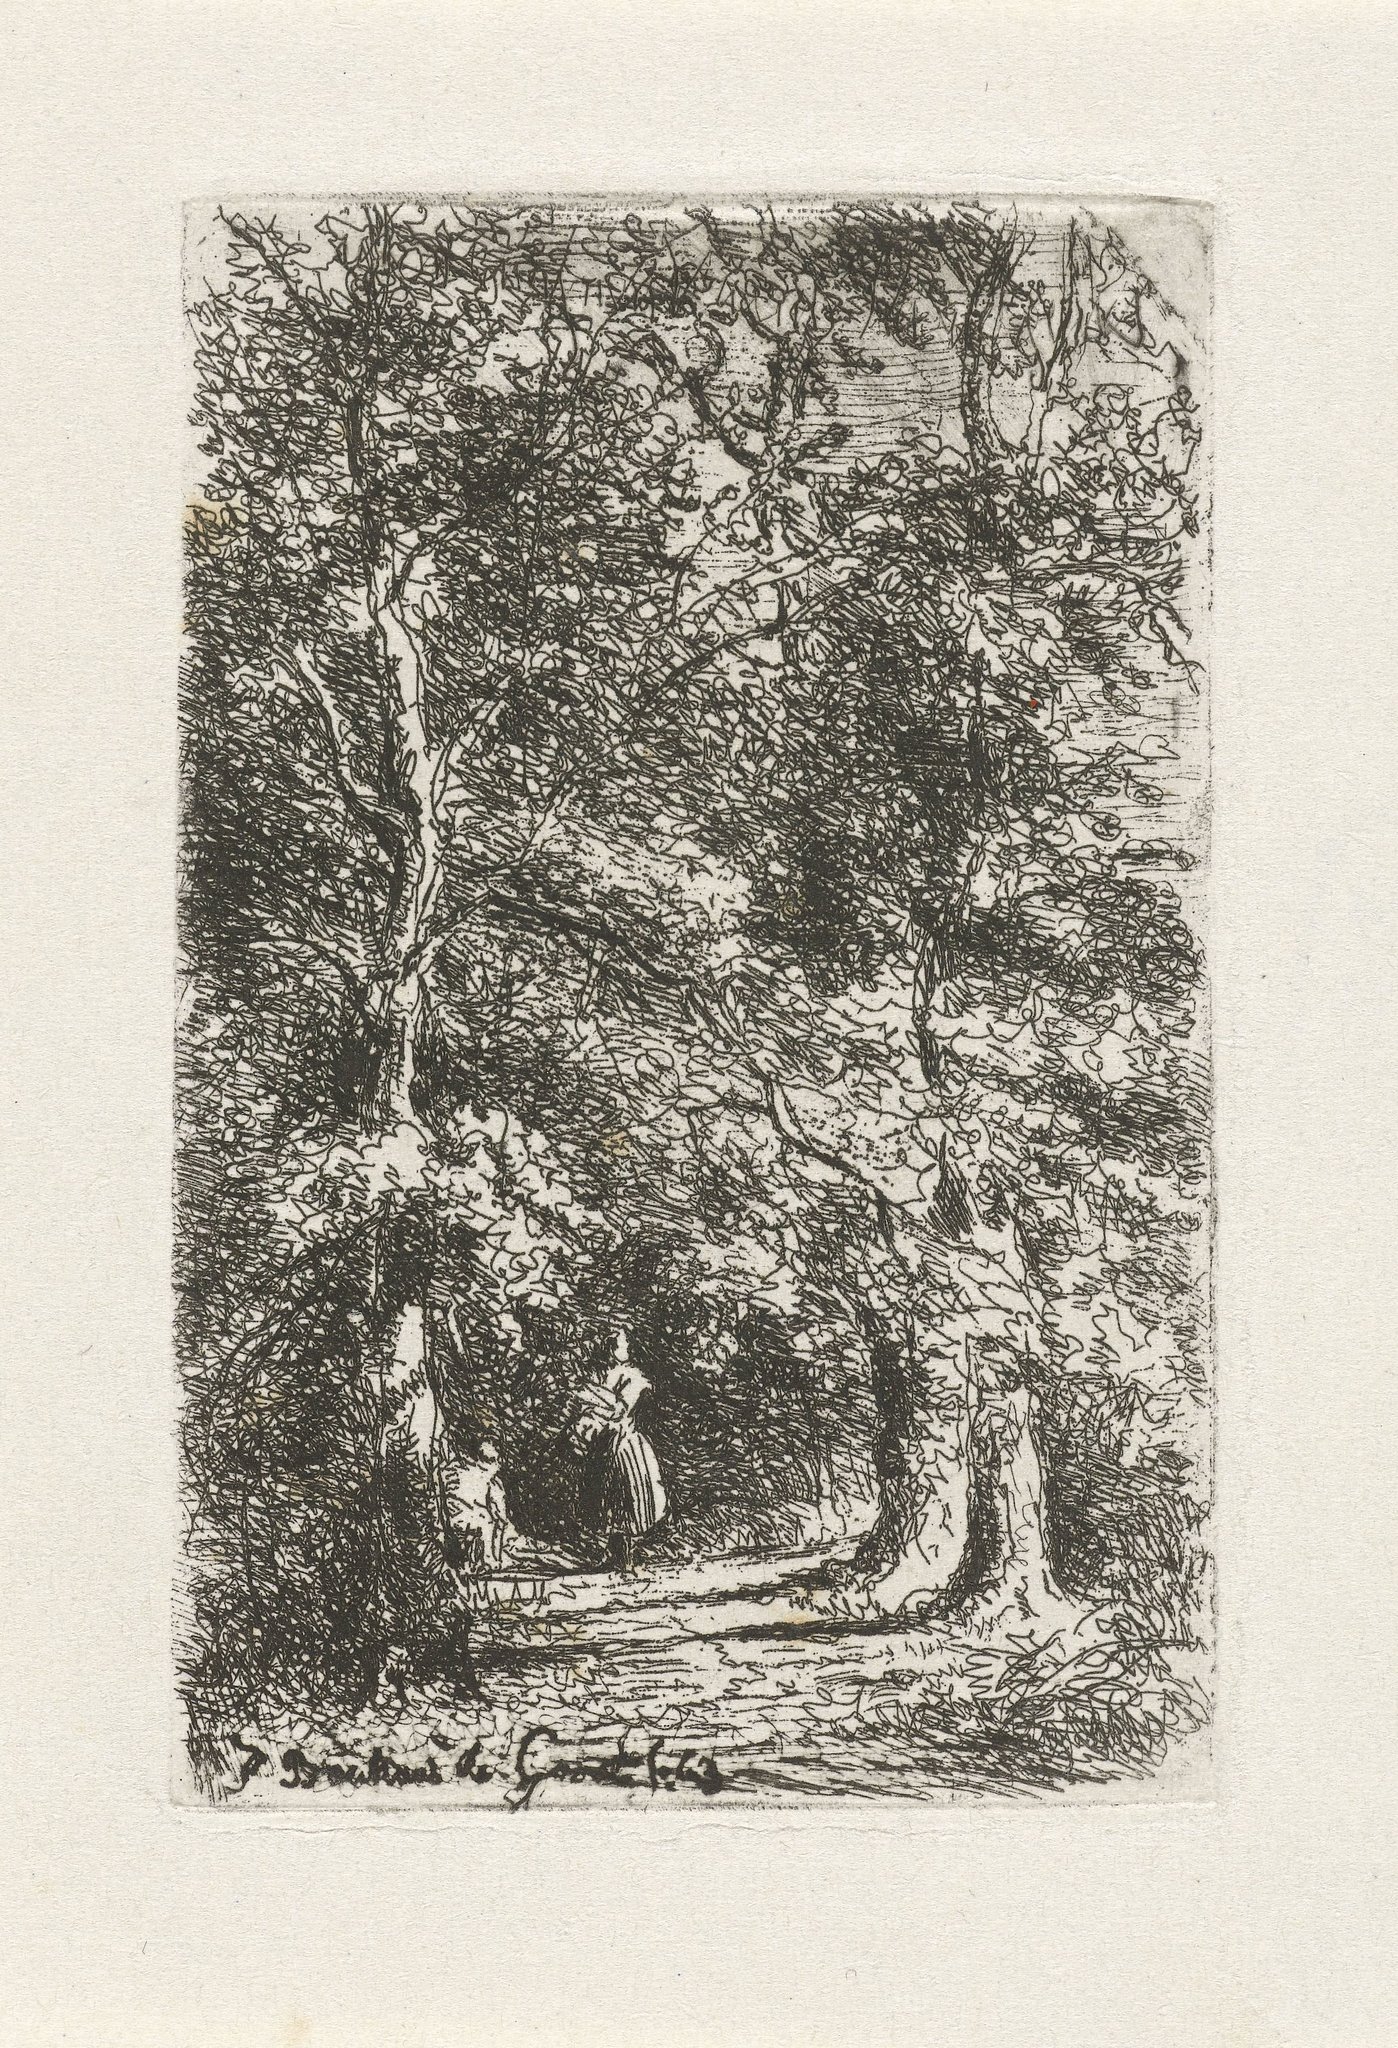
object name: print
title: Vrouw op bospad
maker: j. breuhaus de groot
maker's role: print maker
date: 1900-1999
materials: paper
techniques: etching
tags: forest path or lane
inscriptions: collector's mark: Lugt 2228